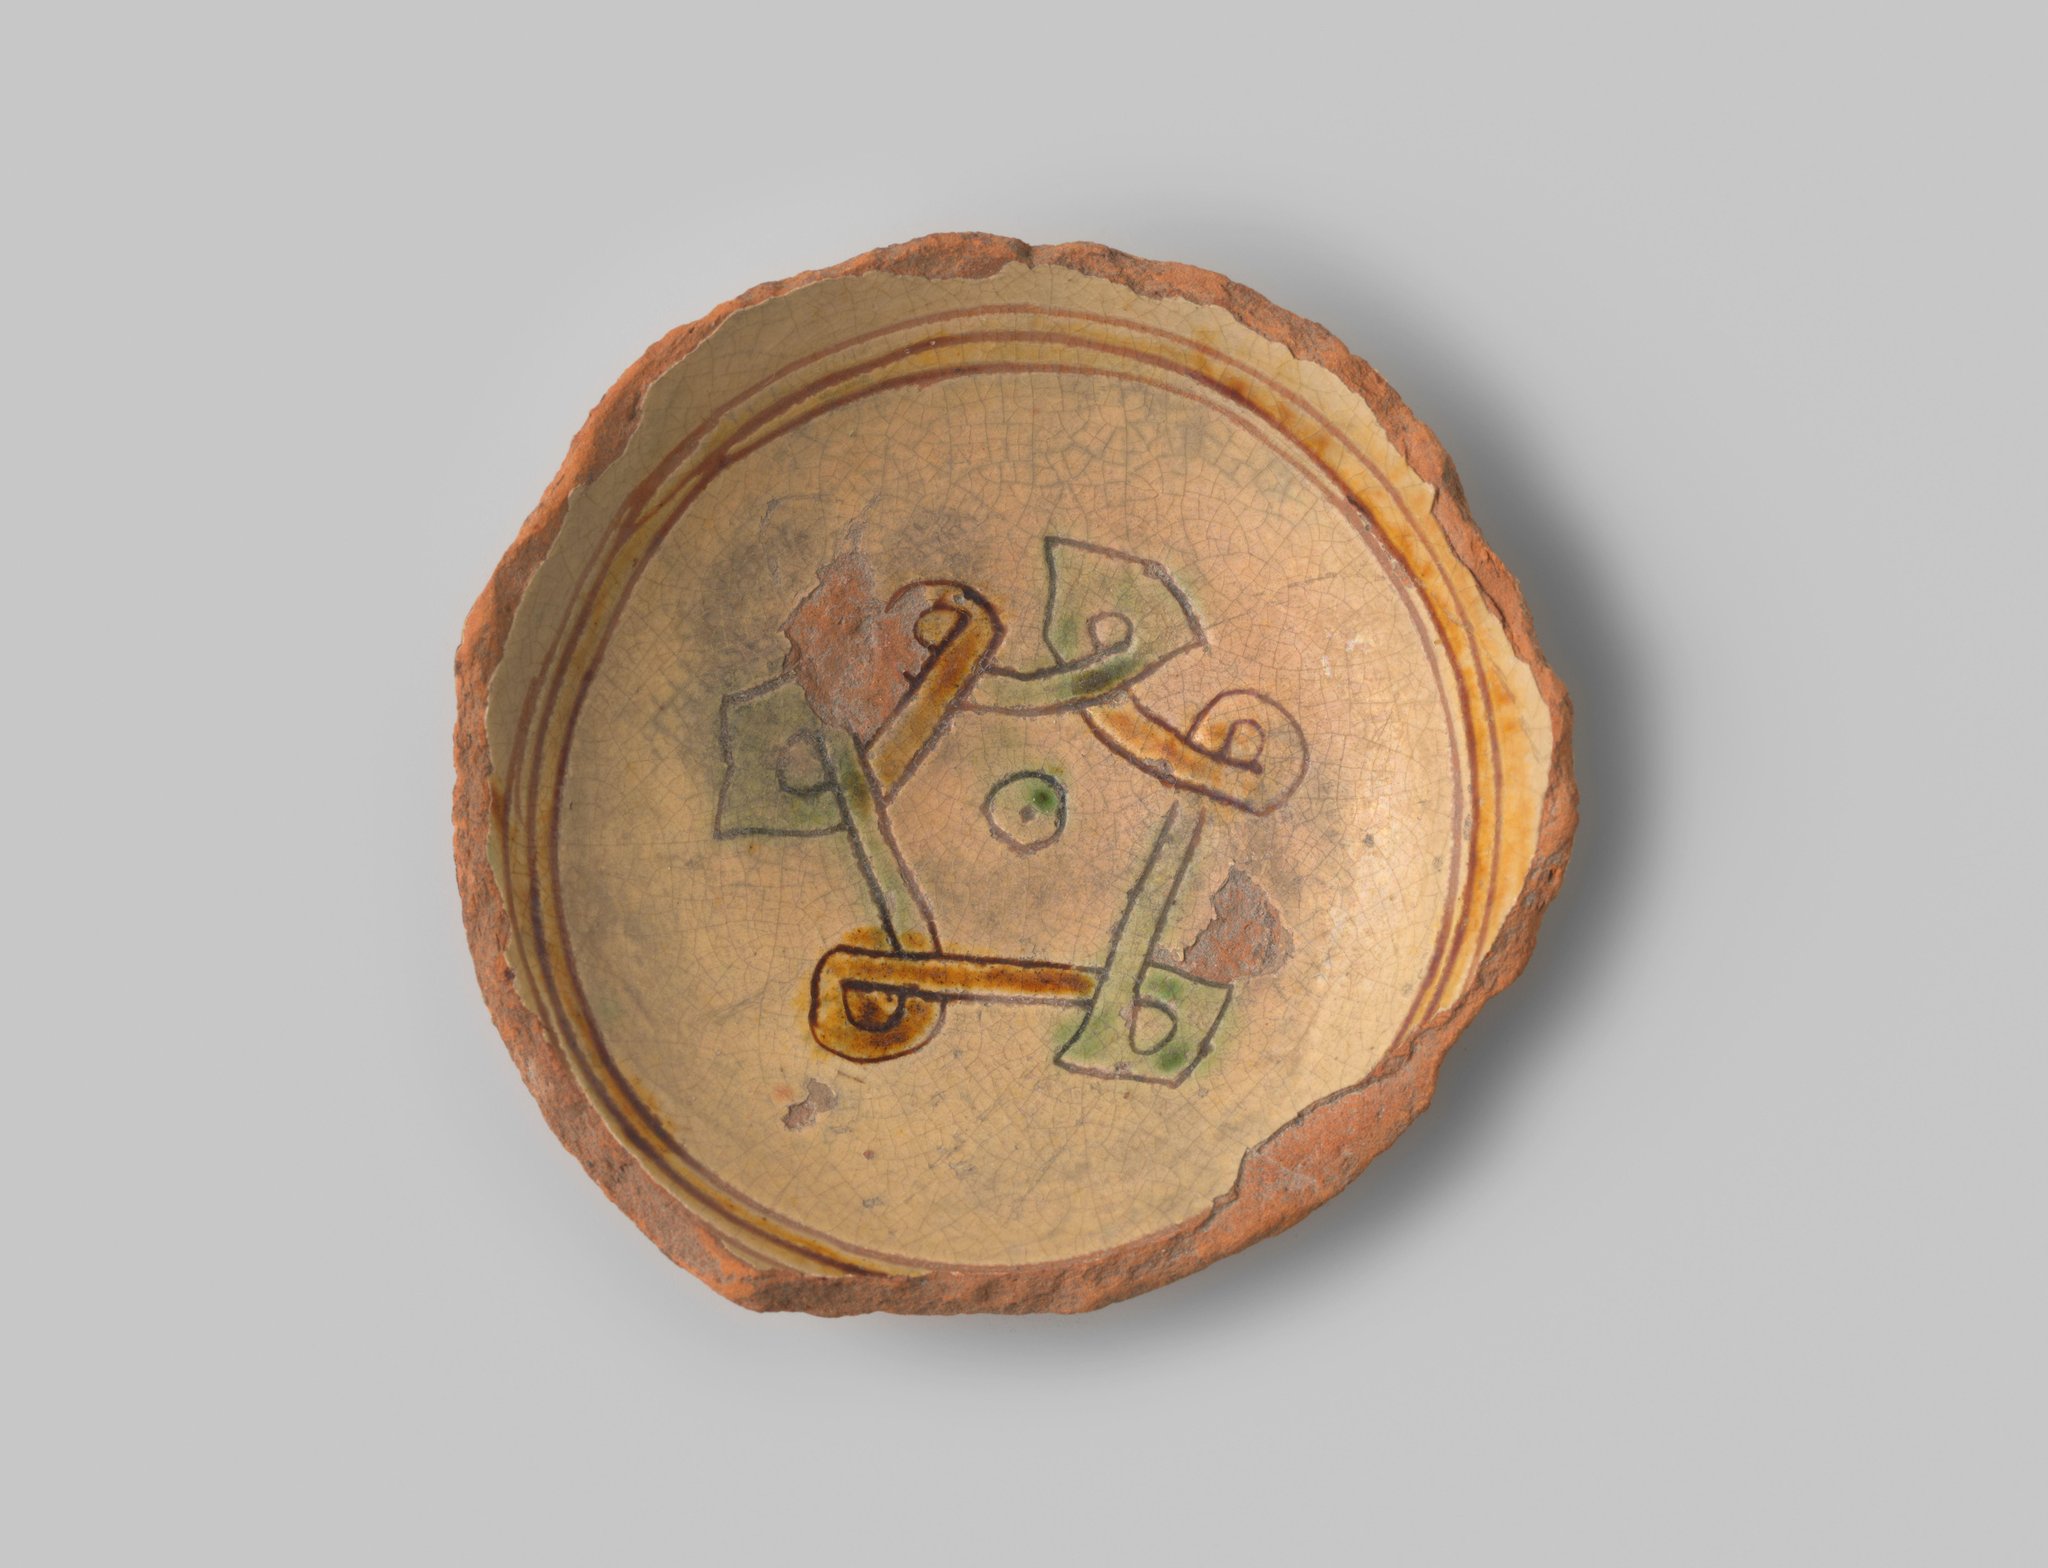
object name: sherd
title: Fragment (voetring) van een schotel met roodbakkende scherf, met aan de voor- en achterzijde geel glazuur, waarop in sgrafitto-techniek met oker en groen glazuur strepen en krullen zijn weergegeven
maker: Anonymous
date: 1200-1899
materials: earthenware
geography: italy